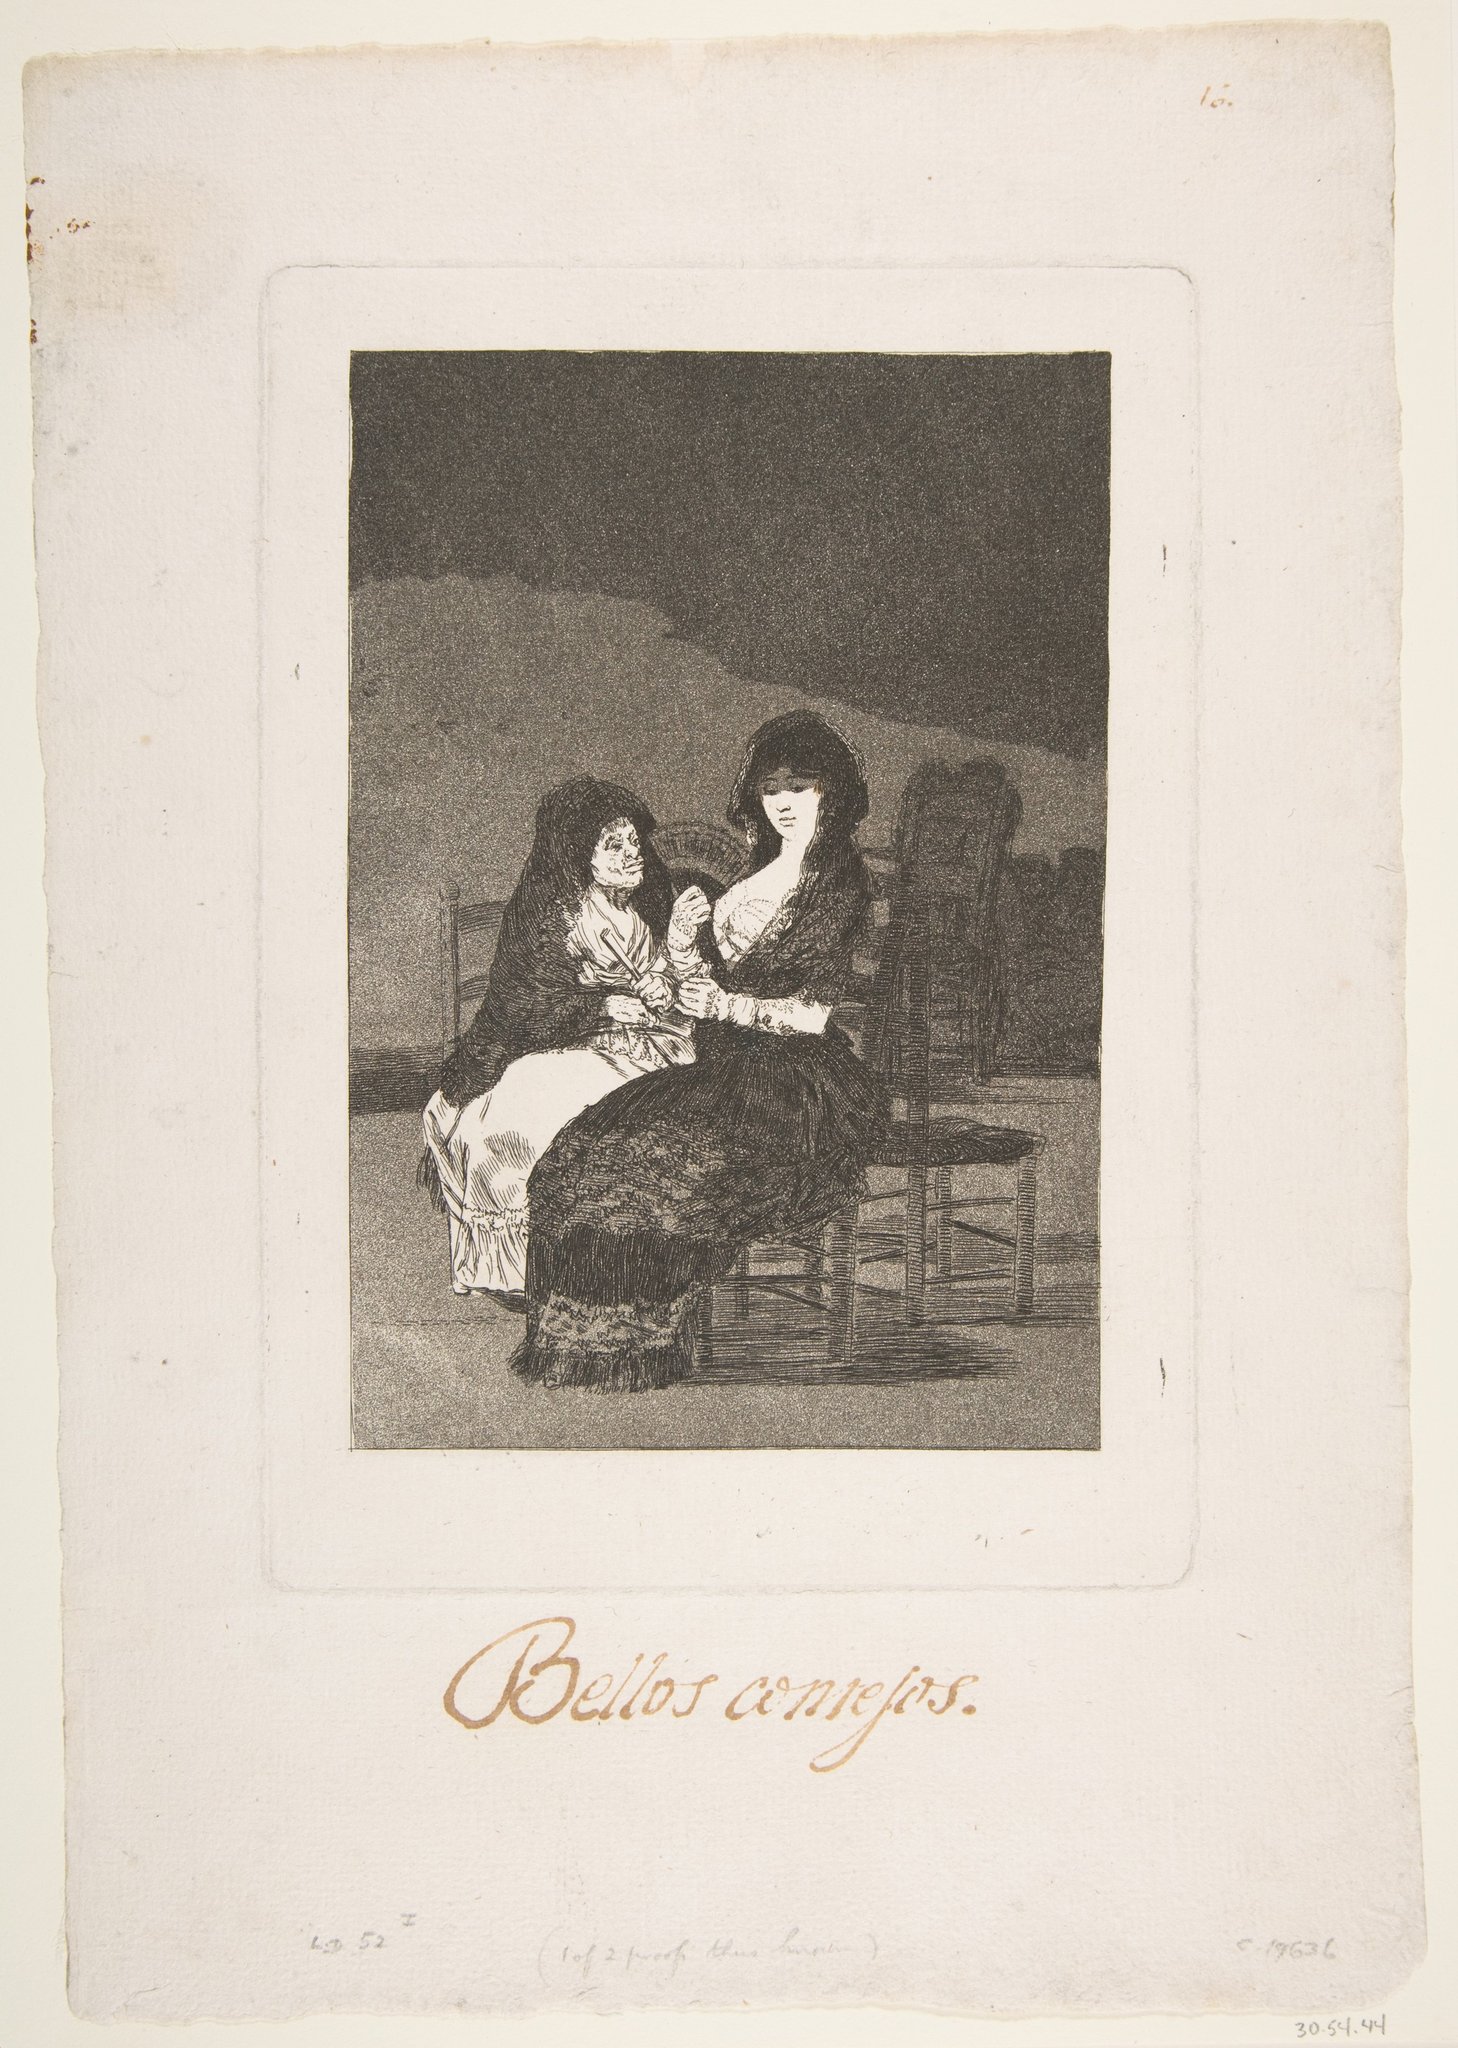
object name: print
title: Plate 15 from 'Los Caprichos': Pretty Advice (Bellos consejos)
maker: goya (francisco de goya y lucientes)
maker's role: artist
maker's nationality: spanish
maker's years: 1746-1828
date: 1799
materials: ink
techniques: aquatint, engraving, etching, pen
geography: spain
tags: women,chairs